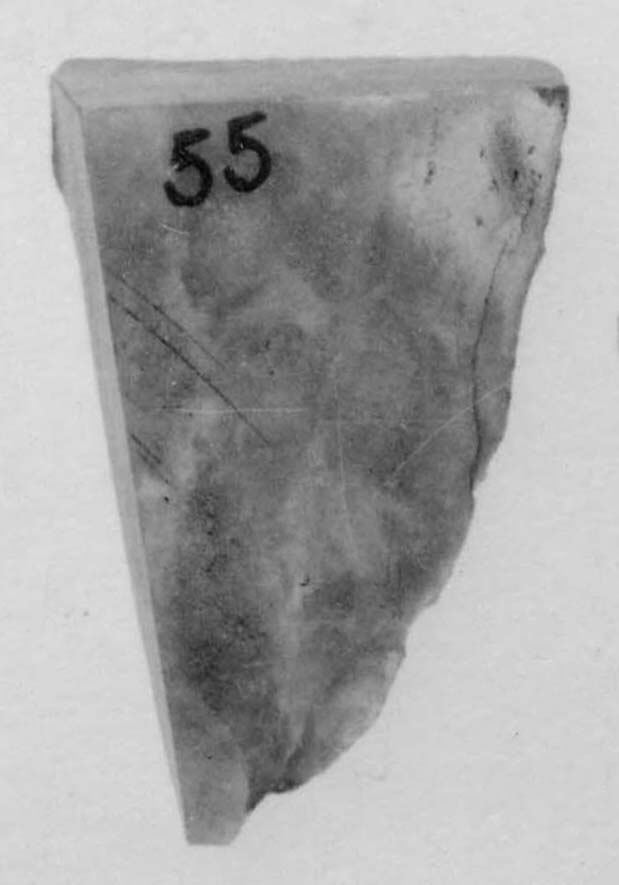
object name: fragment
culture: tibetan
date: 1902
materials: jade